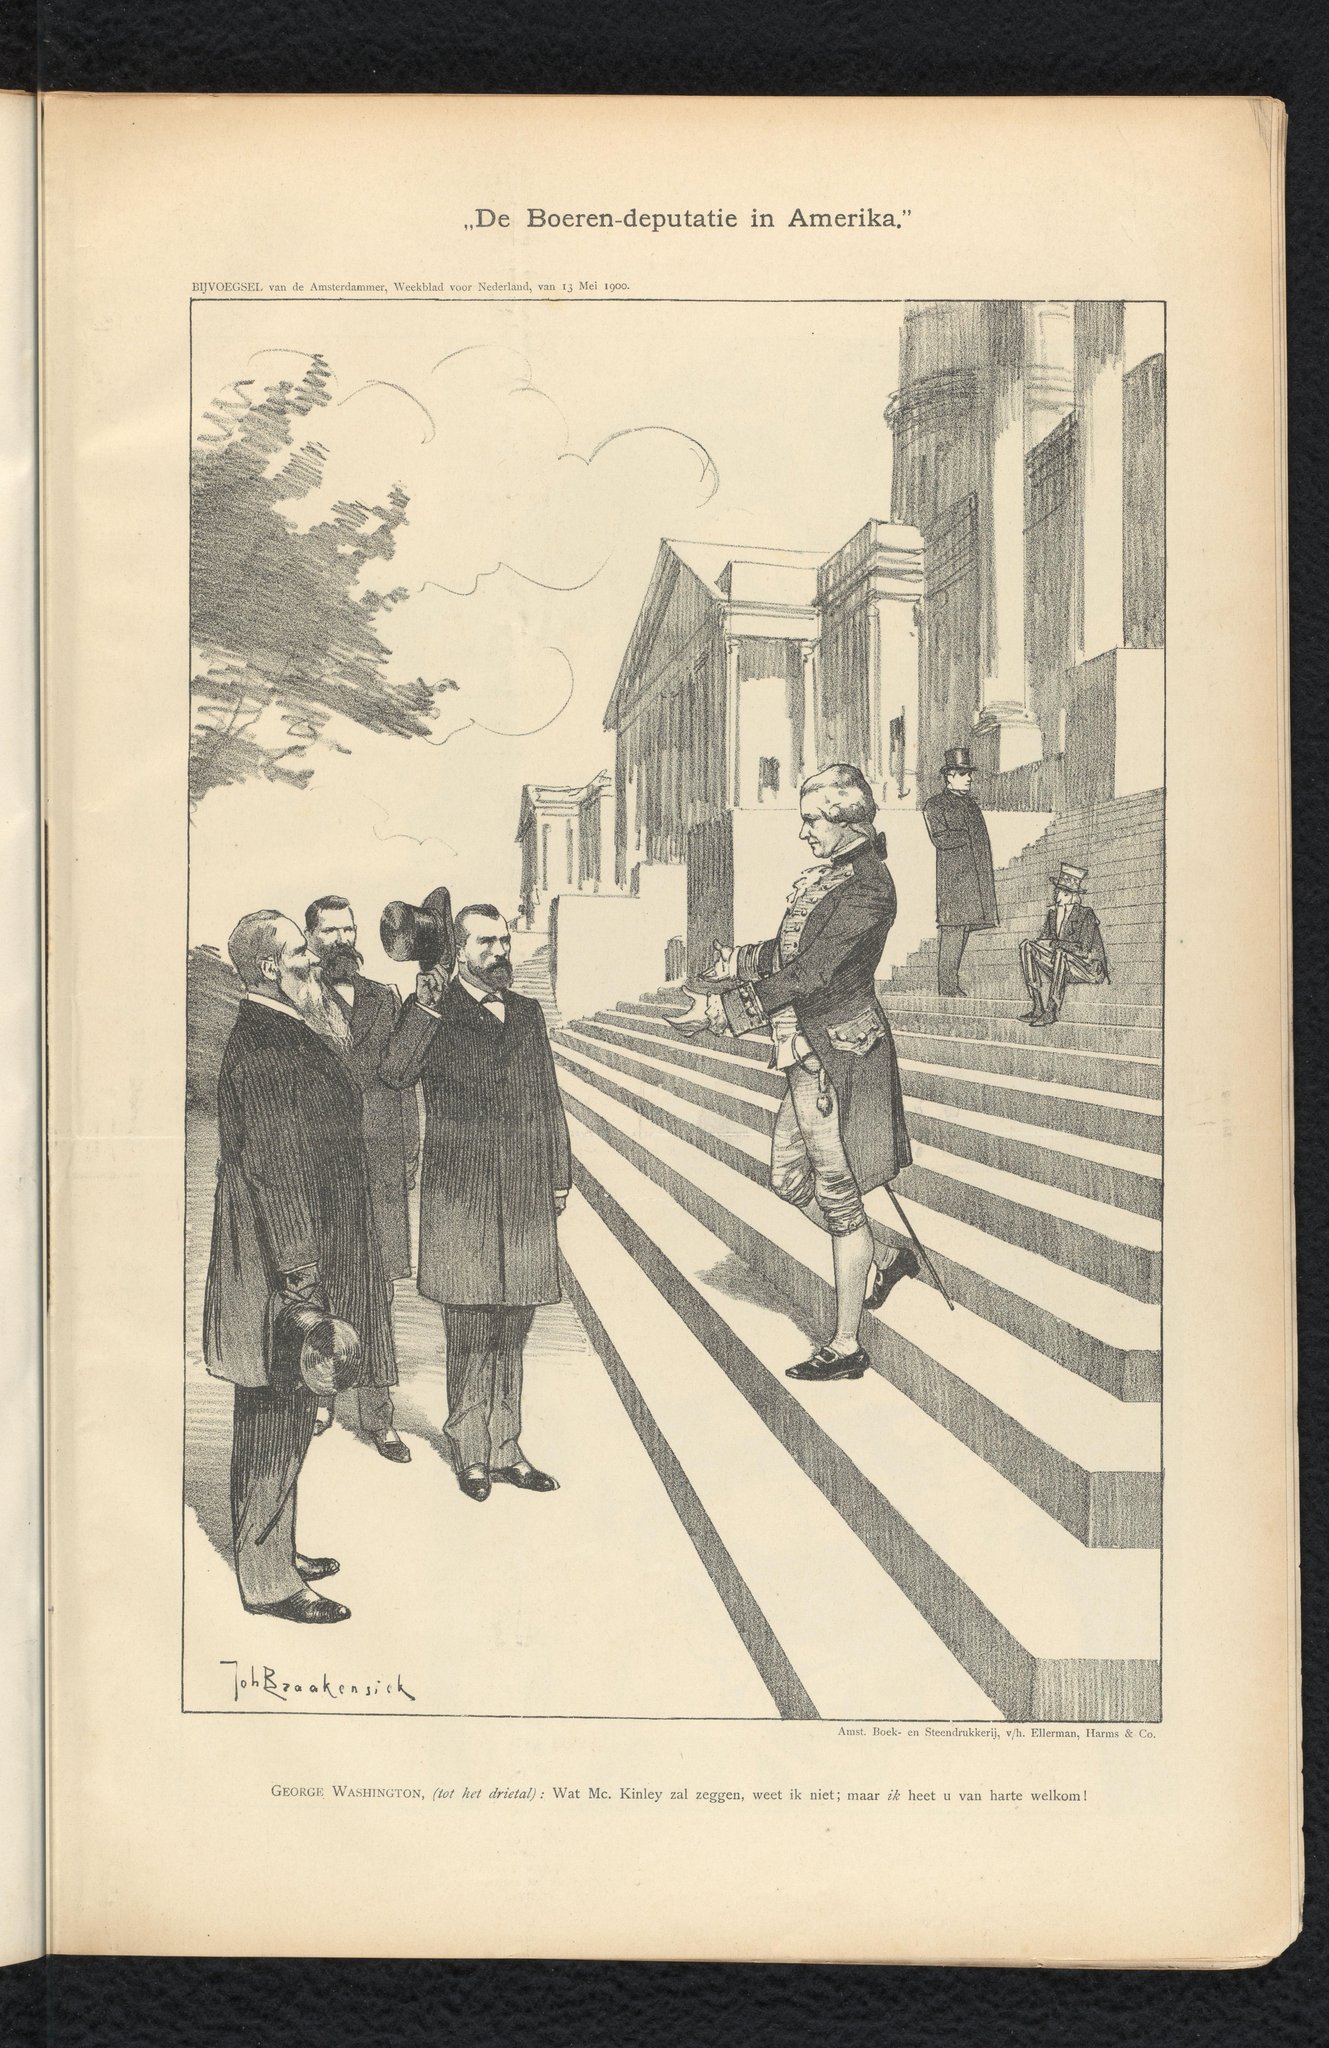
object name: cartoon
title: "De Boeren-deputatie in Amerika"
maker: johan braakensiek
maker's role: draughtsman, print maker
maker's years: 1858-1940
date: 1900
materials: paper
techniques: lithograph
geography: netherlands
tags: politician, personifications of countries, nations, states, districts, etc., being welcomed ~ travelling, political caricatures and satires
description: George Washington ontvangt de delegatie van de Boeren bestaande uit Abraham Fischer, Andries Wolmarans en Cornelius Wessels. Deze delegatie reisde door Europa en de Verenigde Staten om steun te regelen voor de strijd van de Boerenrepublieken. Op de achtergrond wacht Uncle Sam met president McKinley.